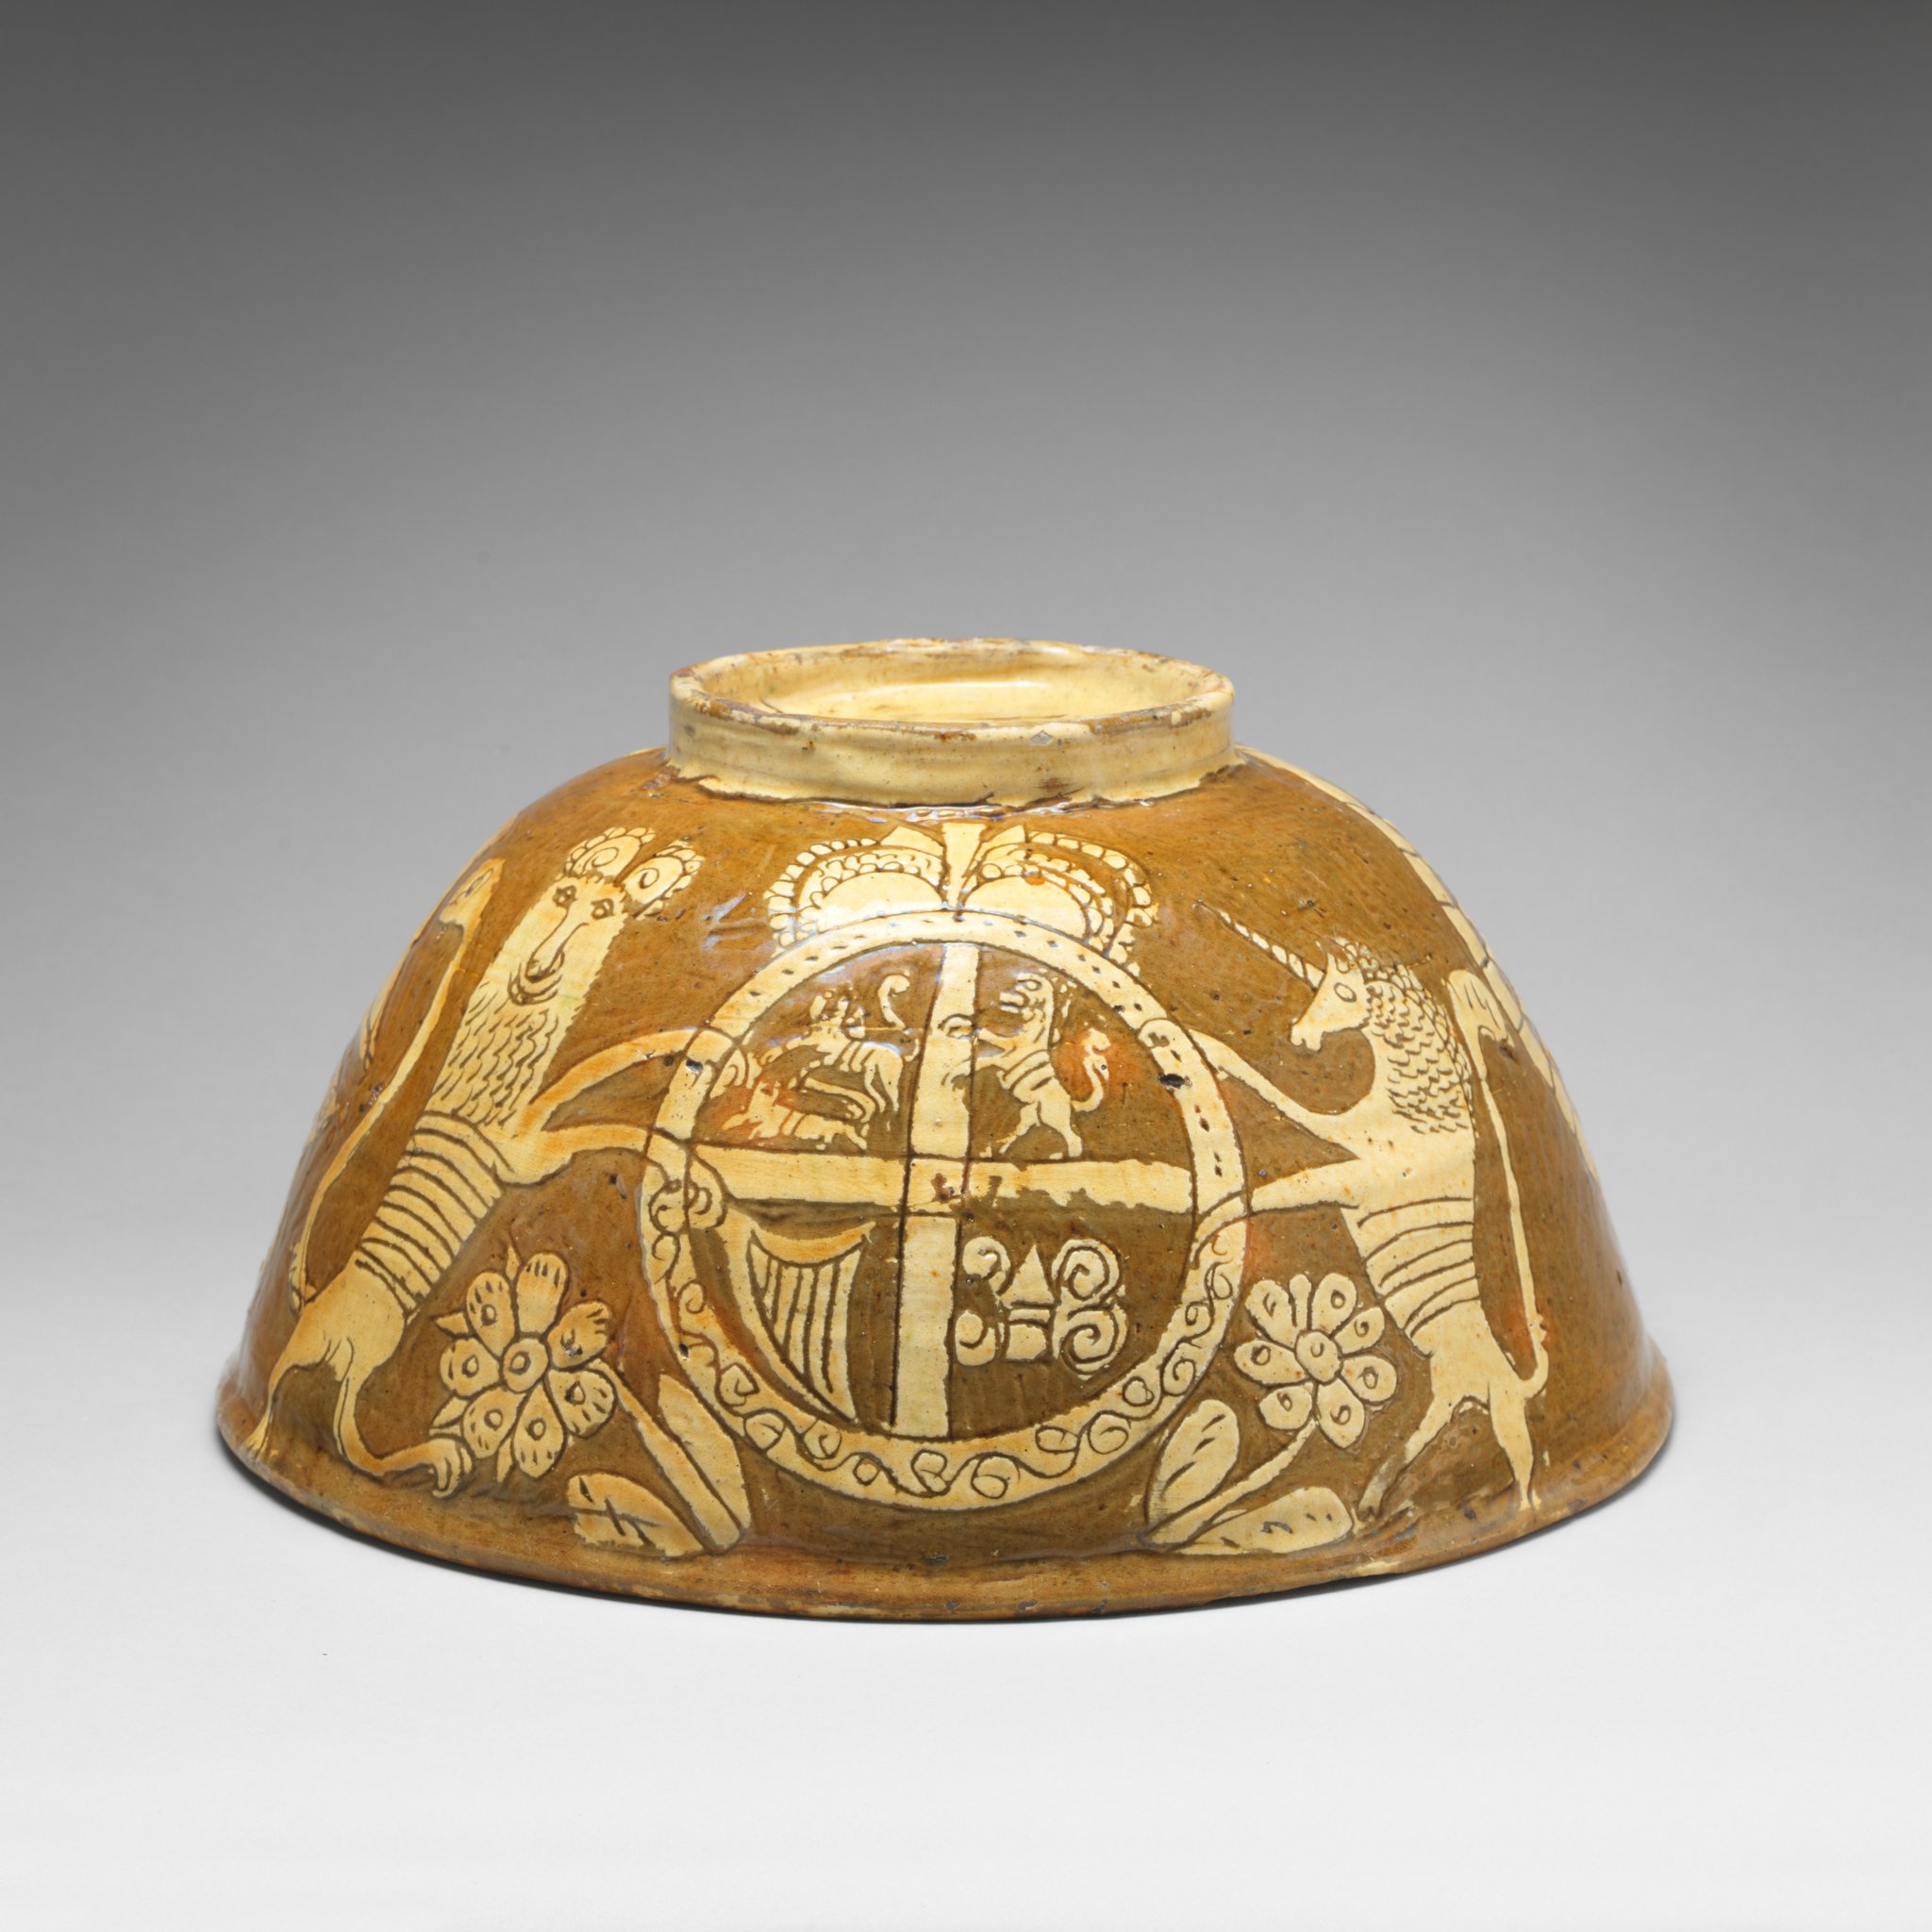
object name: bowl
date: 1751-1775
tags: coat of arms